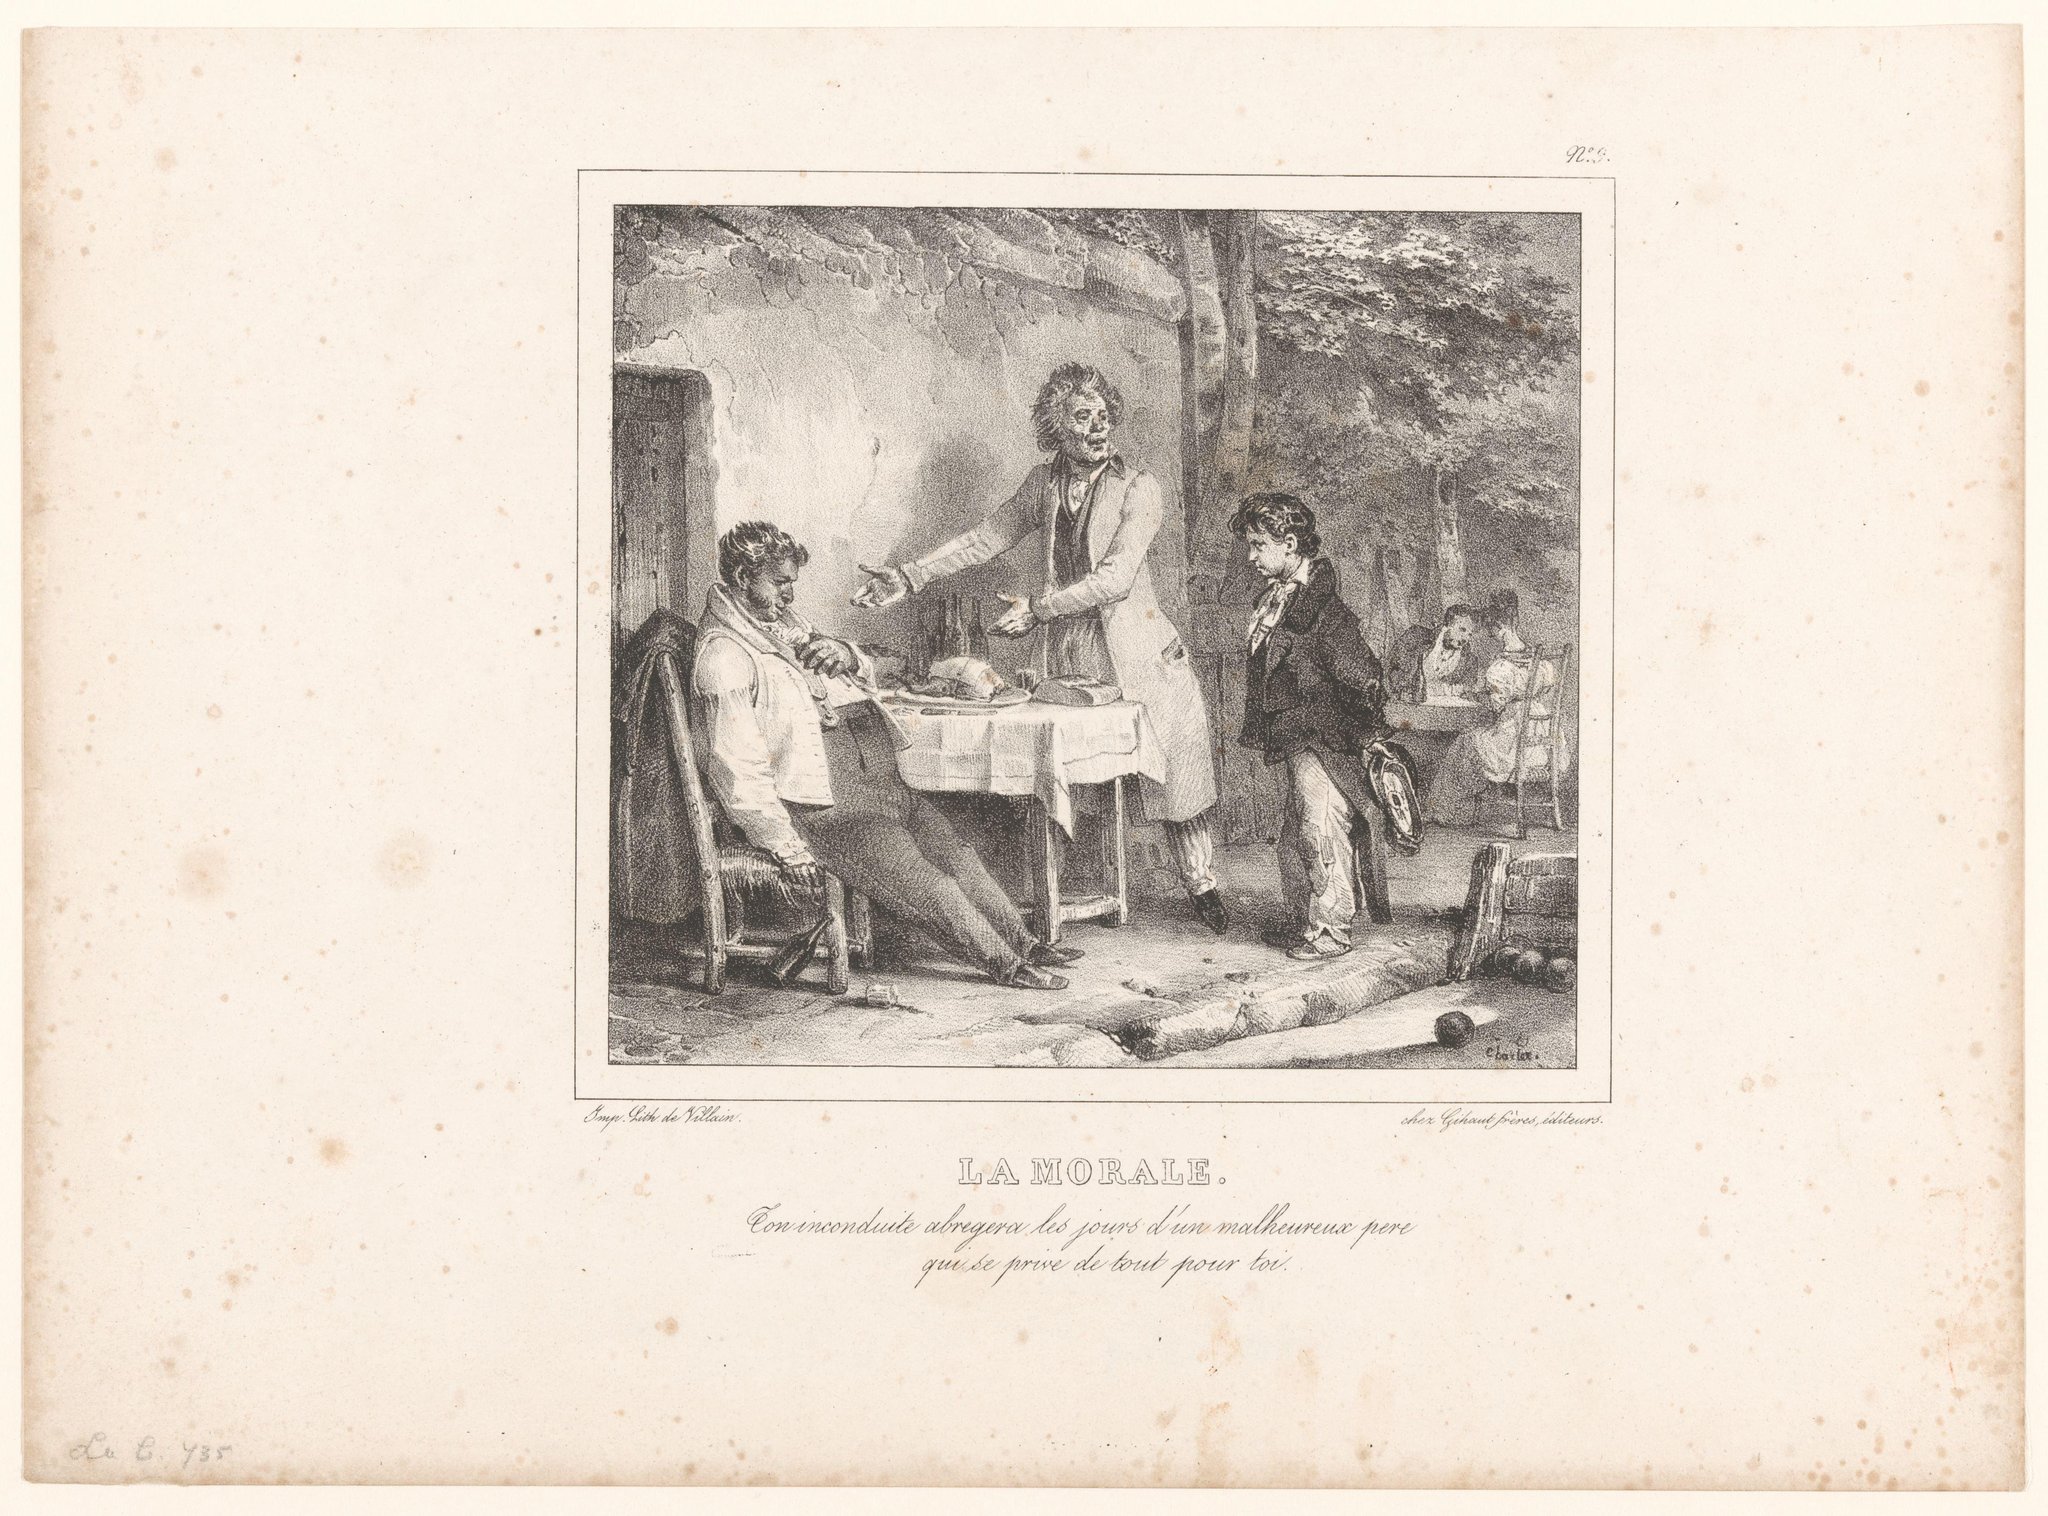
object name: print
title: Jongen ontmoet zijn vader na een overdadige maaltijd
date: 1829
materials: paper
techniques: lithograph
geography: paris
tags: evening meal, dinner, supper - cc - out of doors, father and son(s) (family group), glutton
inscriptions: collector's mark: Lugt 2228a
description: De vader op de stoel is slaperig geworden na een overdadige maaltijd. Een andere man praat diens gedrag goed tegenover het kind: zijn vader heeft het moeilijk door het wangedrag van zijn zoon.